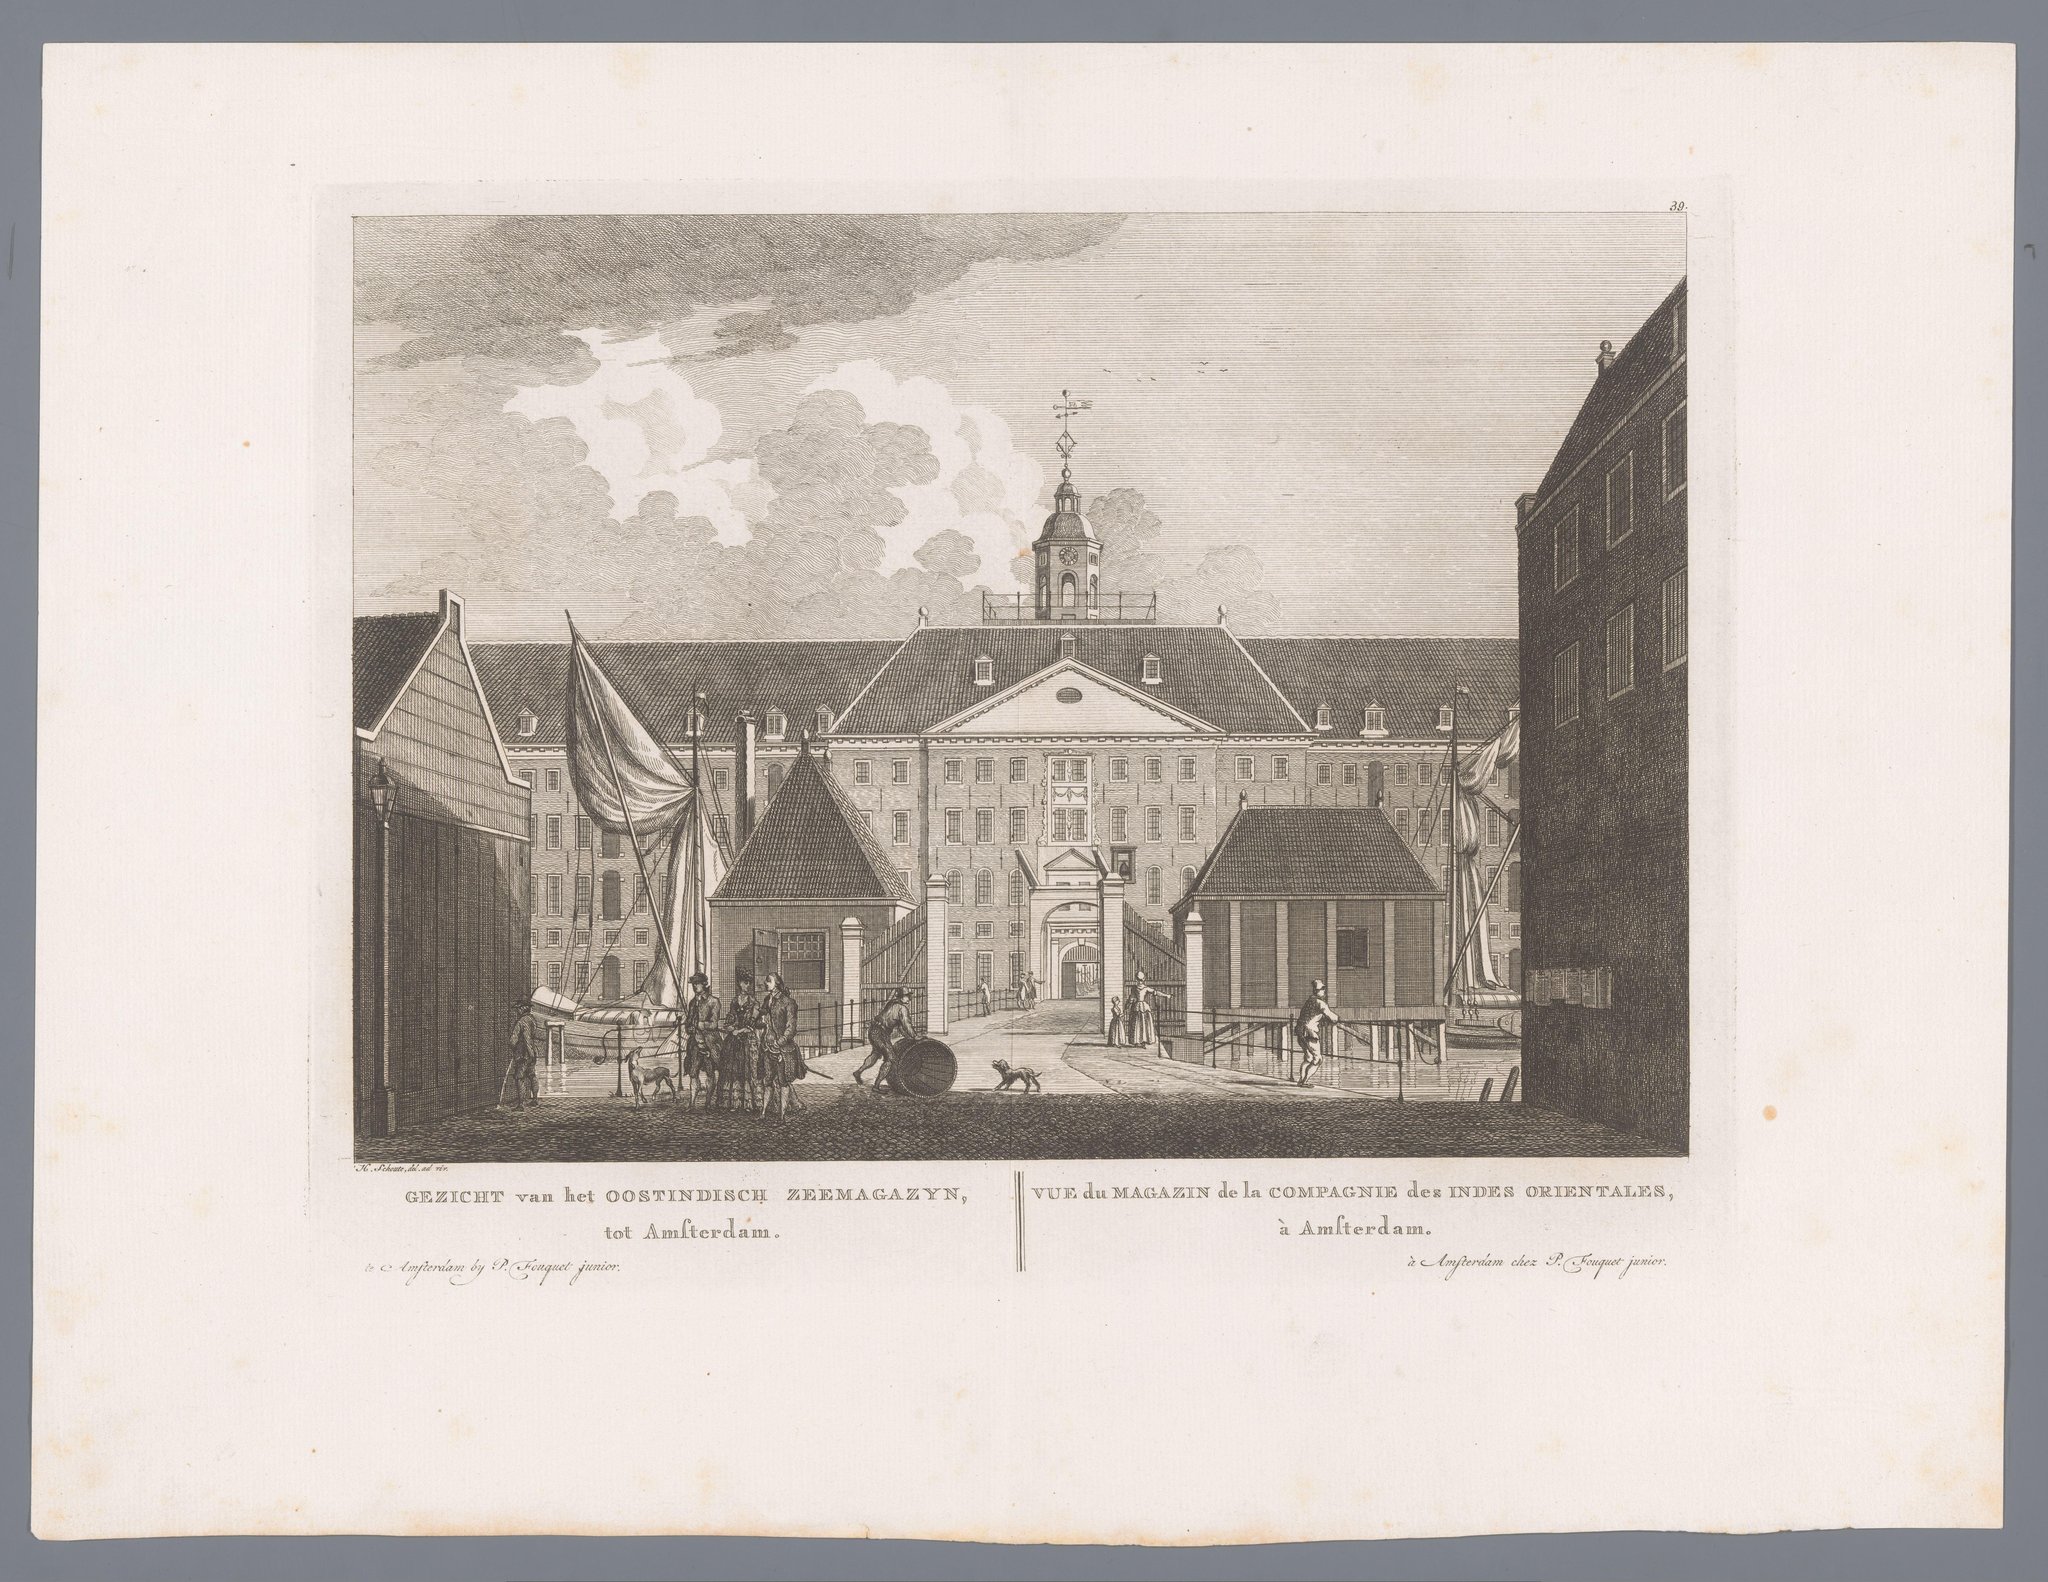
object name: print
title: Gezicht van het Oostindisch zeemagazyn, tot Amsterdam / Vue du magazin de la compagnie des Indes Orientales, à Amsterdam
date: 1778-1783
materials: paper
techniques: engraving, etching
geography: amsterdam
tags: large-scale structure for storage, e.g.: warehouse, depot, silo, trade-company, shipyard, shipdock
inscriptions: collector's mark: Lugt 2228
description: Prent uit een van de edities van de Atlas Fouquet: Afbeeldingen van de wyd-vermaarde koopstad Amsterdam benevens des zelvs voornaamste gebouwen en gezigten alle naar het leeven getekend / Receuil des edifices les plus considerables et des plus belles vues, de la fameuse ville d'Amsterdam, dessinées d'après nature. Amsterdam: Pierre Fouquet, 1778-1783. En: Nieuwe atlas, van de voornaamste gebouwen en gezigten der stad Amsterdam, met derzelver beknopte beschryvingen. 2 dln. Amsterdam: Daniël Jean Changuion en Petrus den Hengst [in opdracht van Pierre Fouquet], 1783. Een latere staat komt voor in: Nieuwe atlas, van de voornaamste gebouwen en gezigten der stad Amsterdam. Met derzelver beknopte beschryvingen. Amsterdam: Evert Maaskamp, 1805.